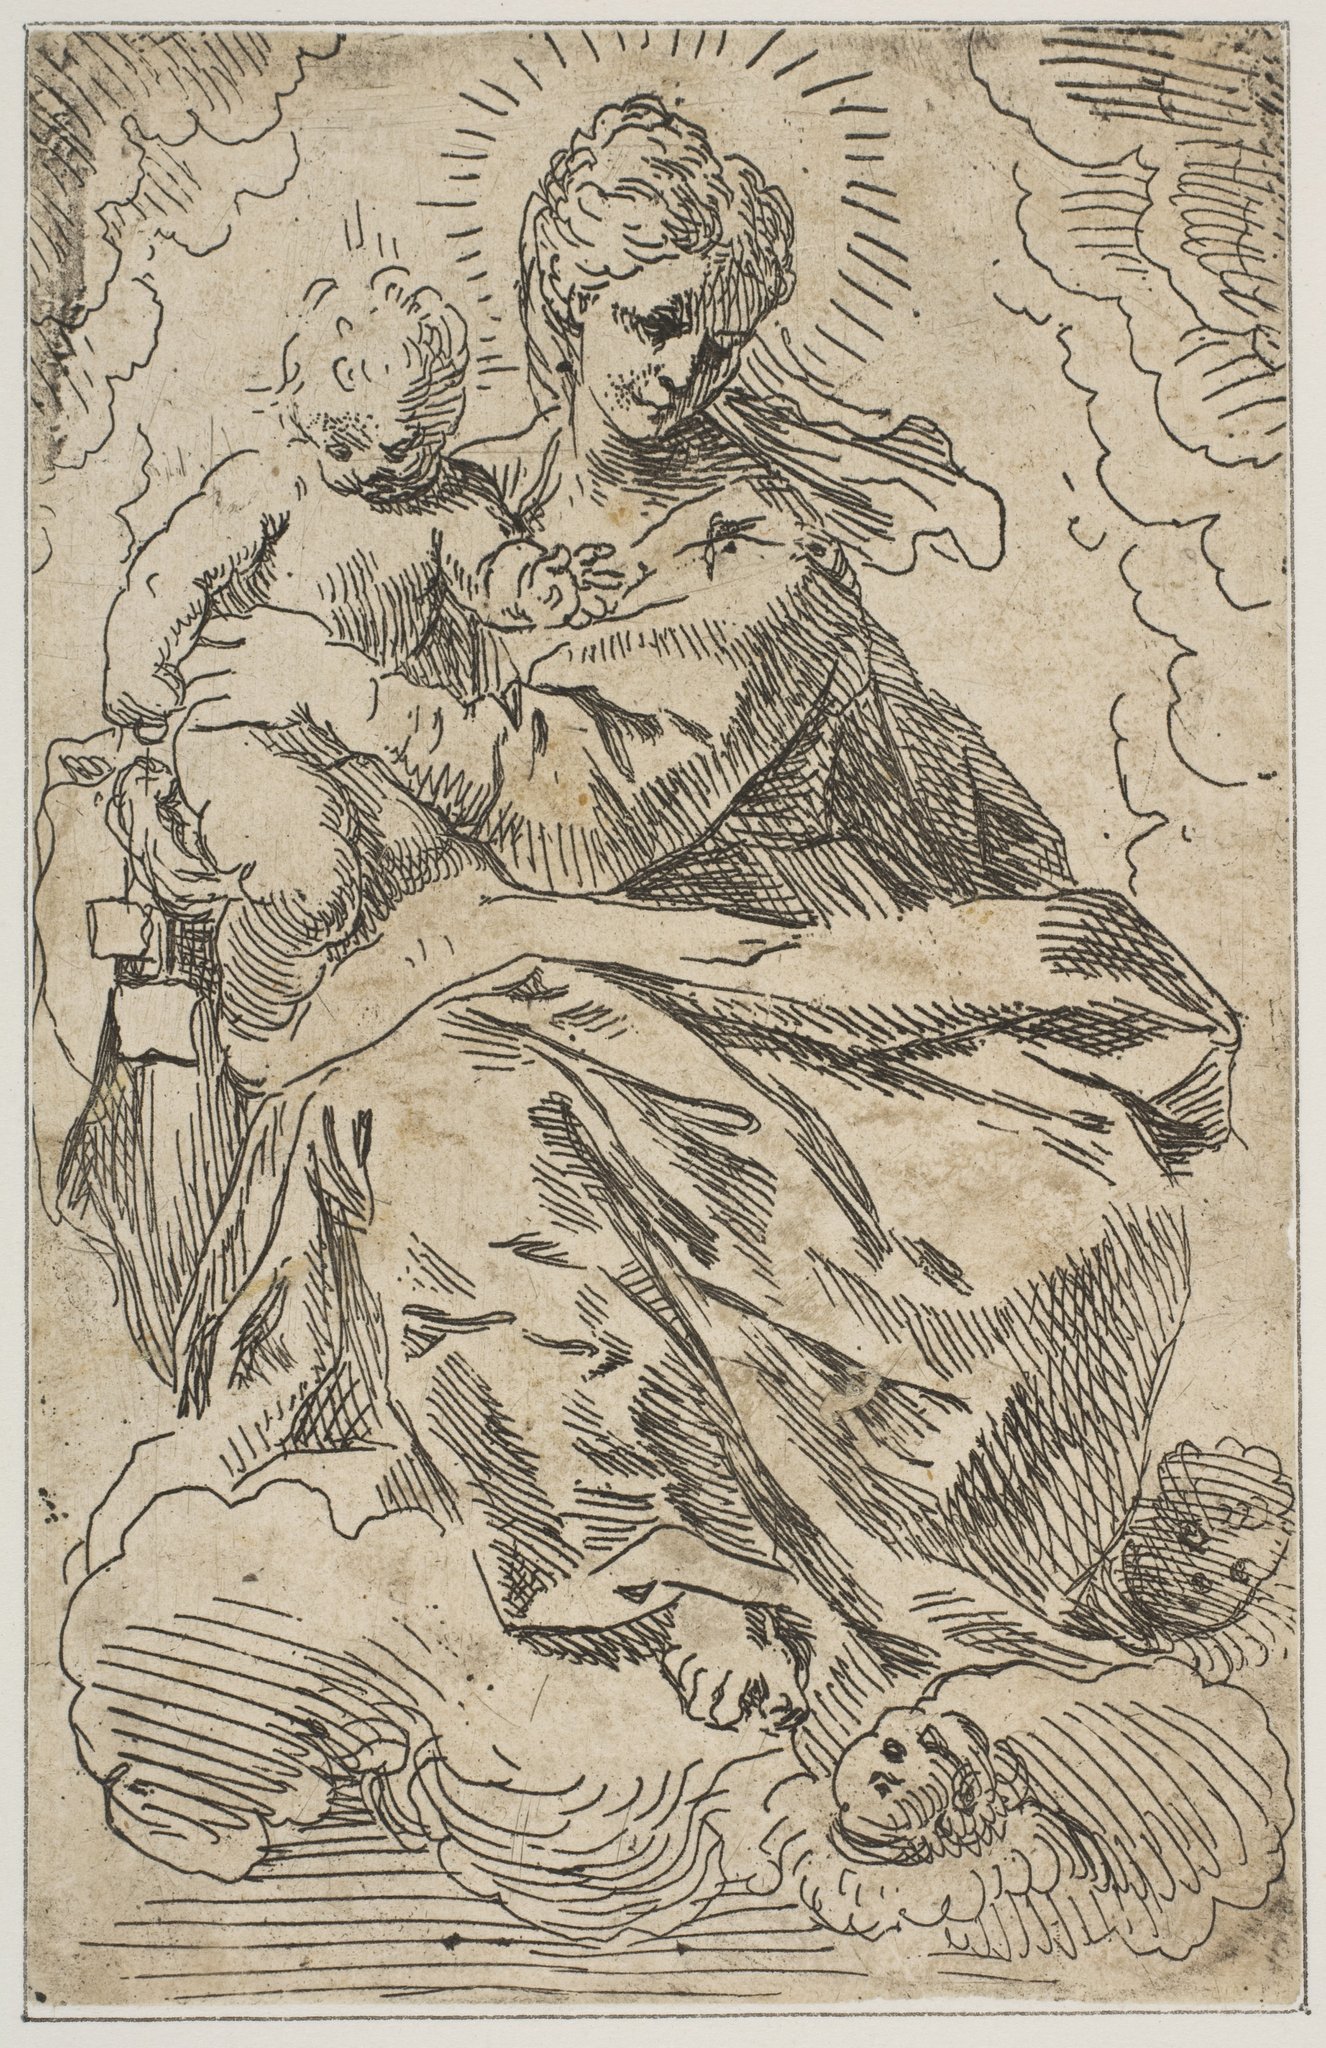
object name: print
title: Madonna and child on clouds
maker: simone cantarini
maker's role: artist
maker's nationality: italian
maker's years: 1612-1648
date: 1601-1700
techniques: etching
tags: madonna and child